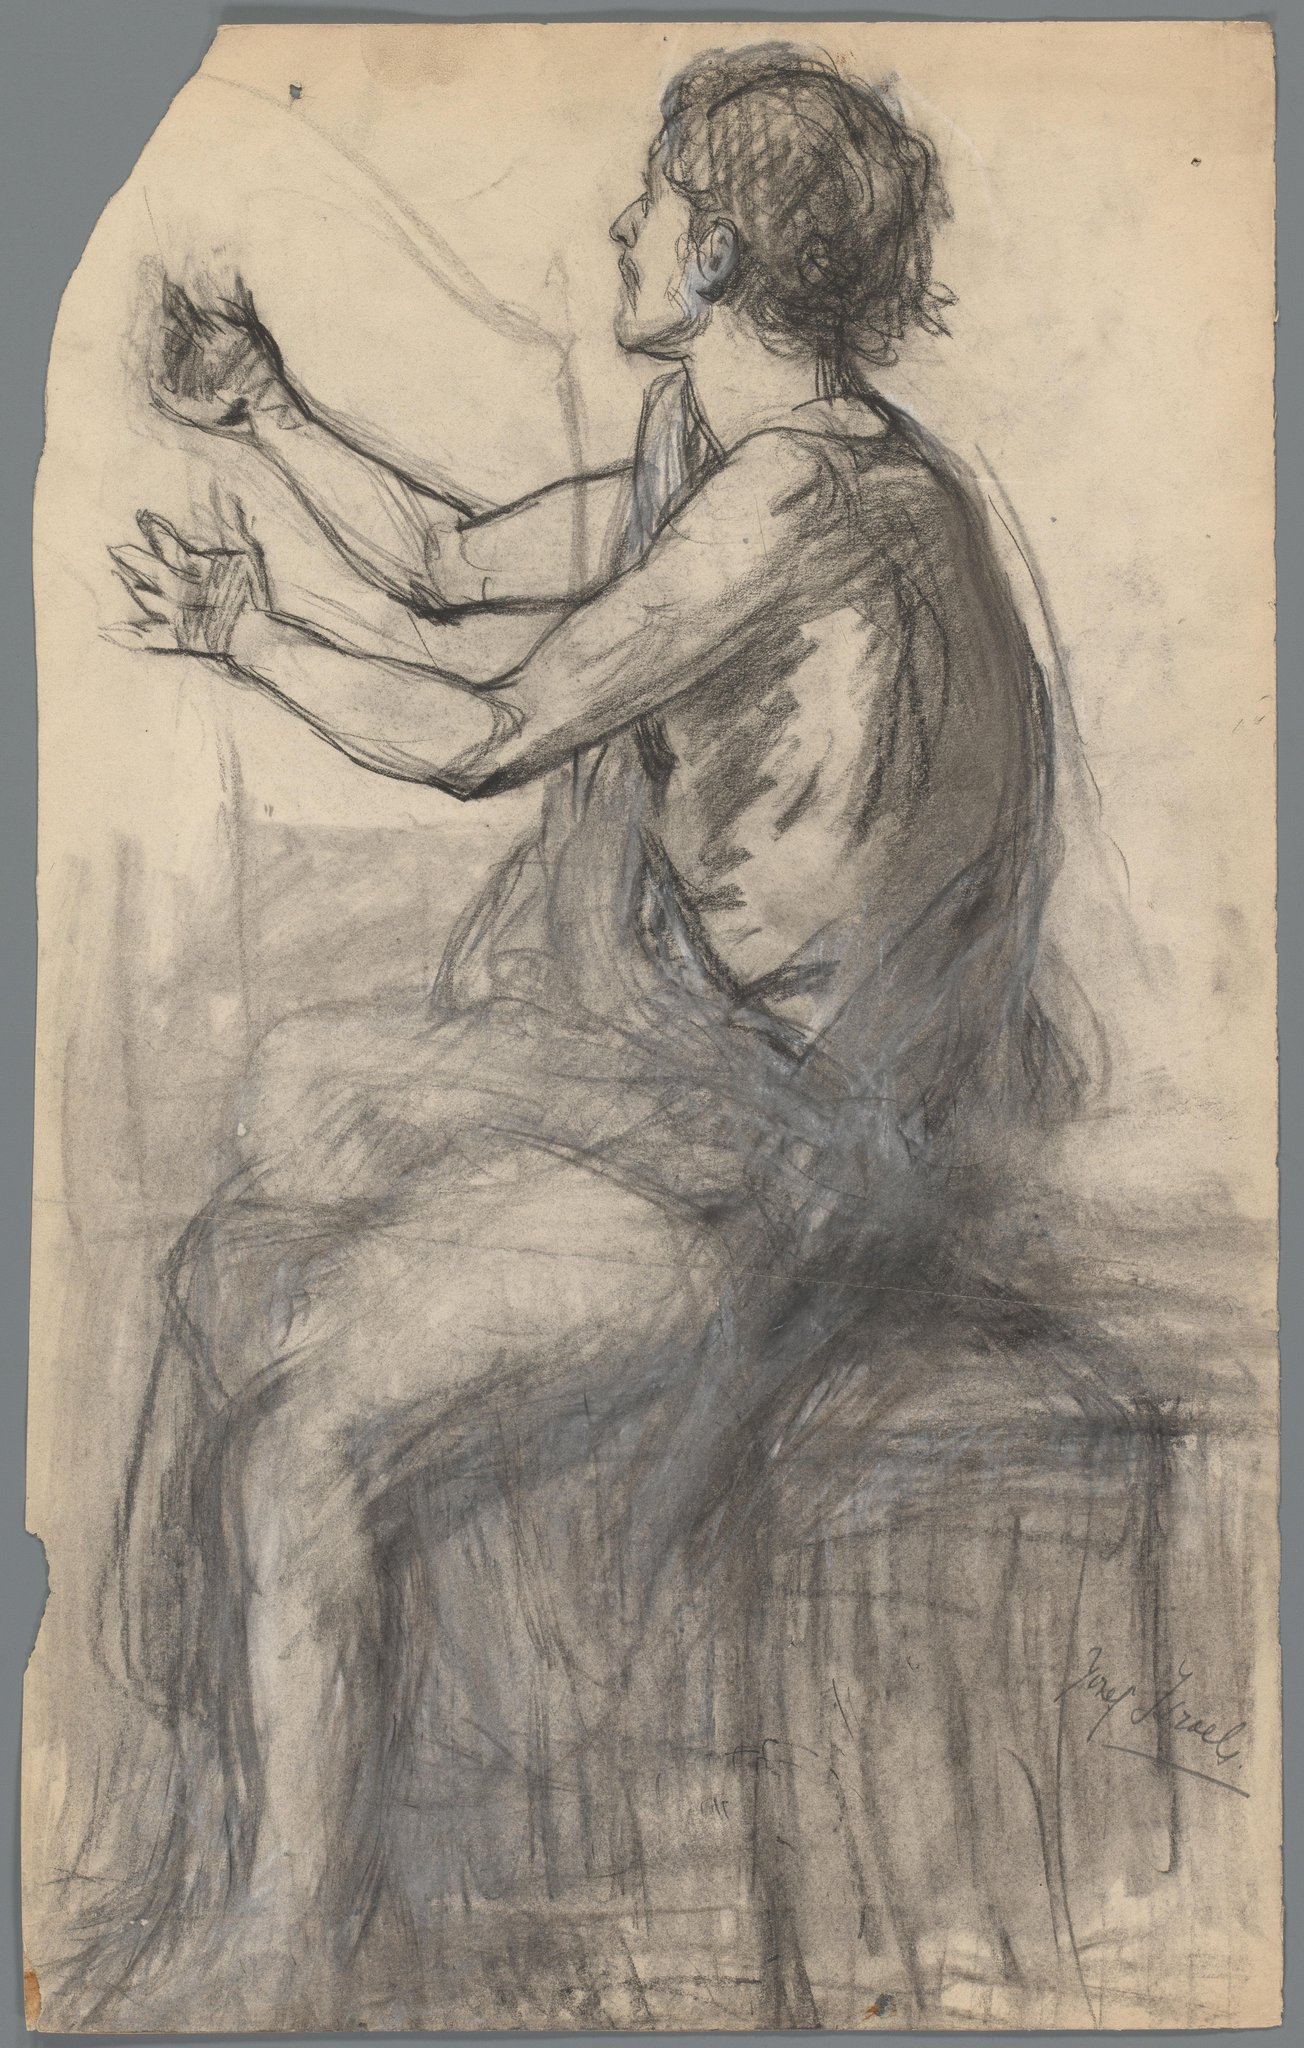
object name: drawing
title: Harpspelende David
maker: jozef israëls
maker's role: draughtsman, painter, print maker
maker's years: 1824-1911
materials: chalk, paper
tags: david as musician, usually playing the harp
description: Voorstudie voor het schilderij 'David en Saul' dat zich in het Groninger Museum bevindt.